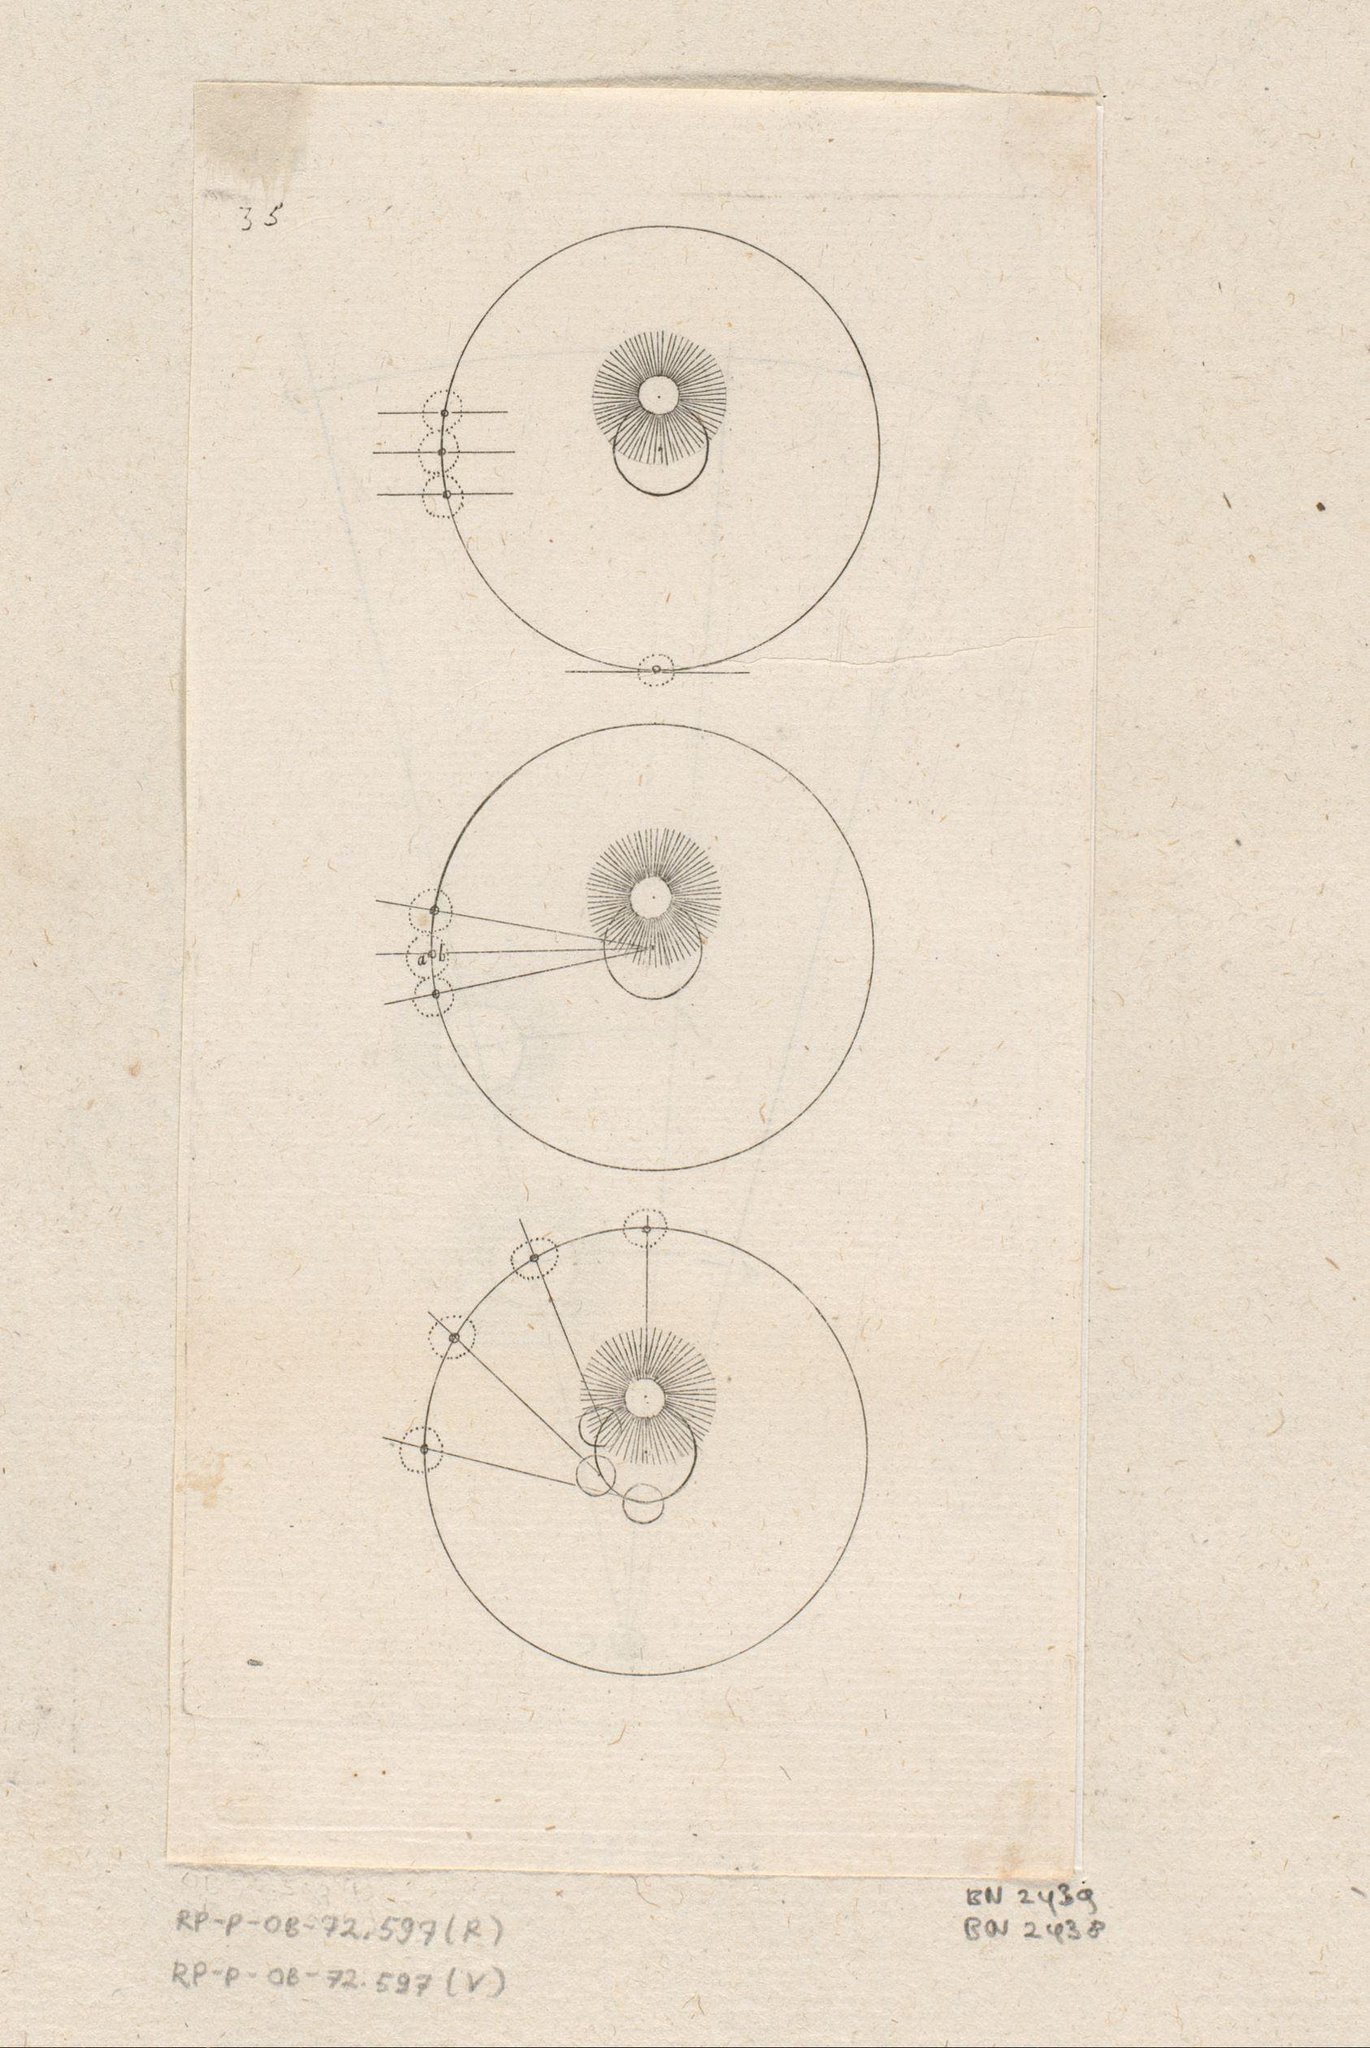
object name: print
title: Revolutie van de Aarde en de Zon rond het centrum van de wereld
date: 1706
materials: paper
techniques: etching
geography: paris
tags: earth, world as celestial body, sun as celestial body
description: Prent uit: Leclerc, Sébastien. Nouveau systeme du monde conforme à l'Ecriture sainte. Où les phénomènes sont expliquez sans excentricité de mouvement (...). Paris: Pierre Giffart, 1706.